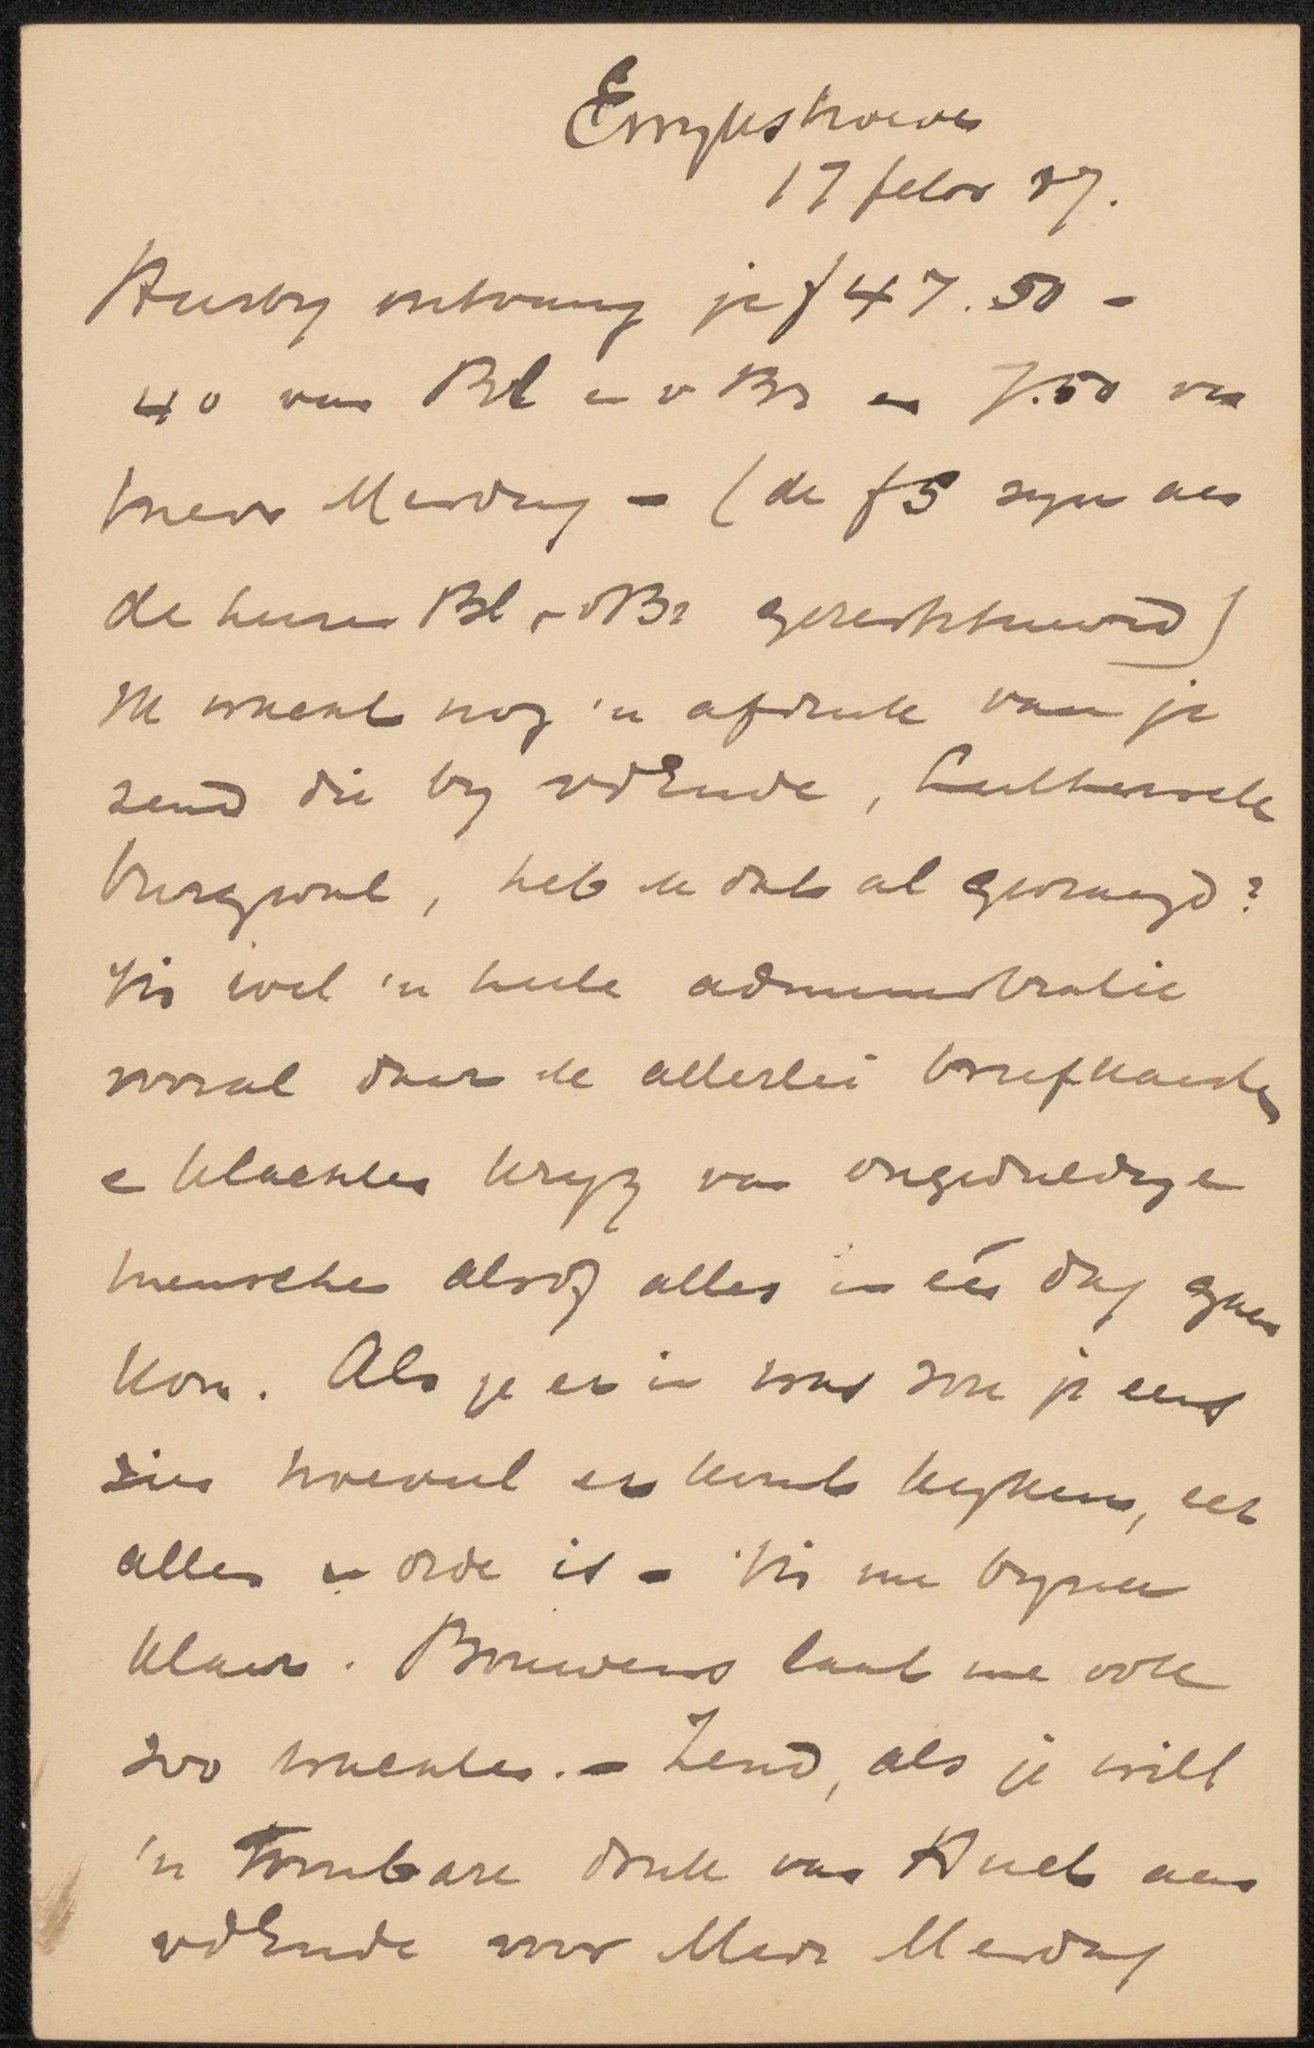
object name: letter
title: Brief aan Jan Veth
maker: willem witsen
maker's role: draughtsman, painter, print maker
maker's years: 1860-1923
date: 1887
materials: ink, paper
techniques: pen, writing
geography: ewijkshoeve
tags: bernardus johannes blommers, designer, jan veth, hendrik willem mesdag, arnhem, painter, print maker, draughtsman, anton mauve, martinus mouton, publisher, the graphic arts, money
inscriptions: watermark, collector's mark: ‘RPK’